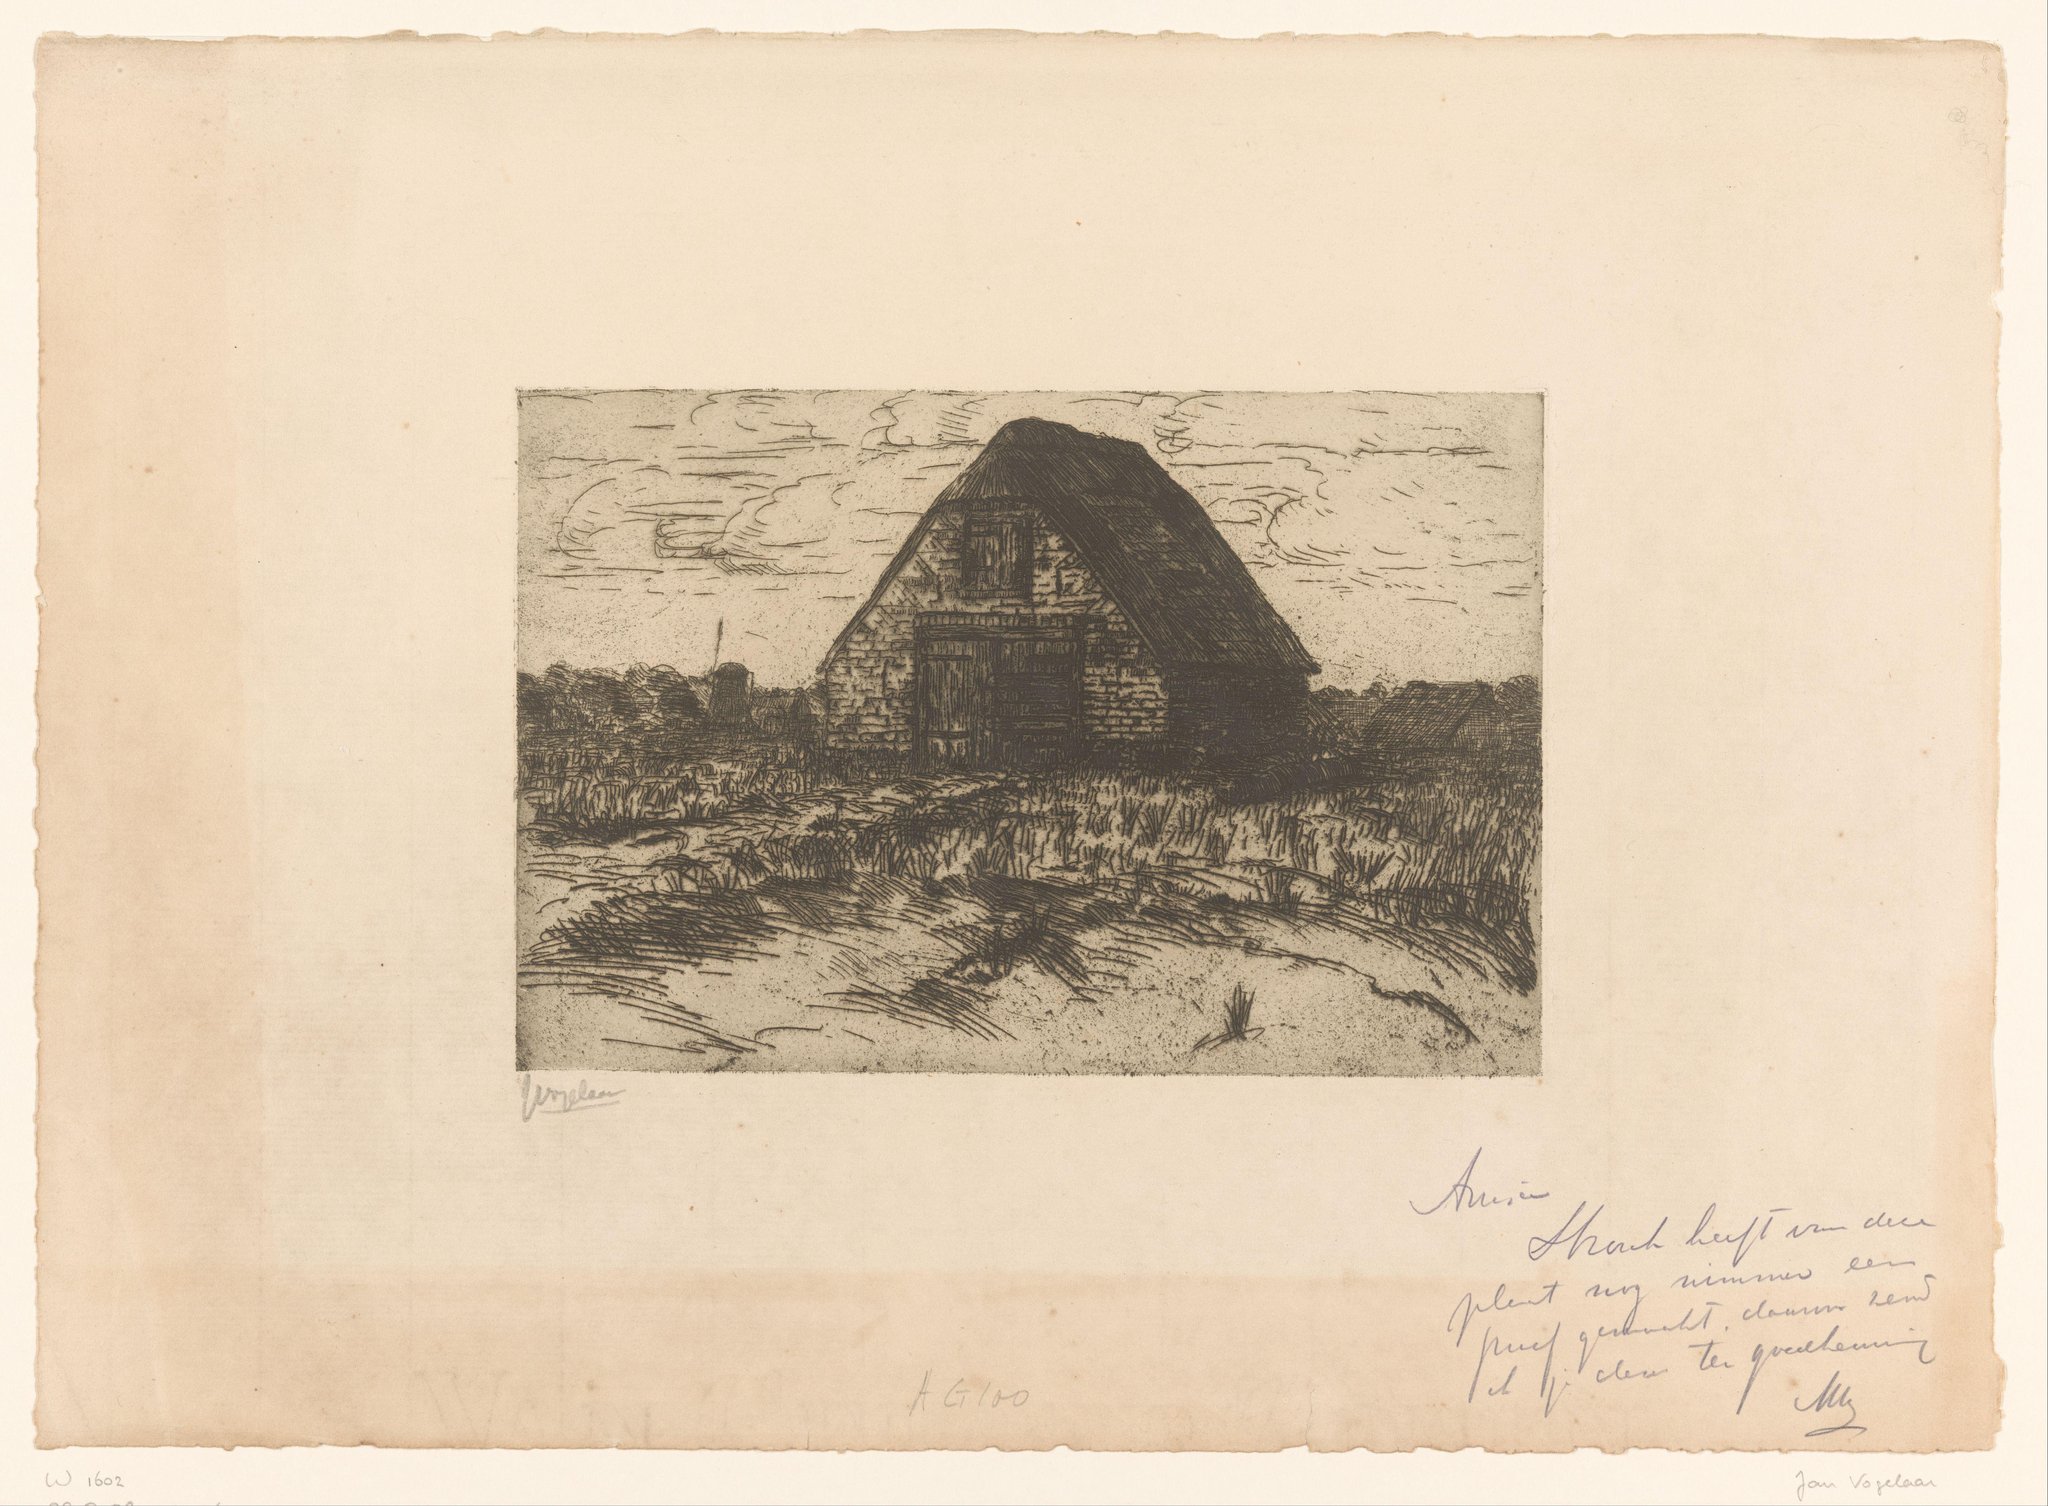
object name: print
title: Landschap met boerenhut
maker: johannes vogelaar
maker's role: draughtsman, painter, print maker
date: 1880-1935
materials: paper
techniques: etching, intaglio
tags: hut, cabin, lodge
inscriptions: annotation: ‘Amice/ [...] heeft van deze/ plaat nog nimmer een/ proef gemaakt, daarom zend/ ik je deze ter goedkeuring’